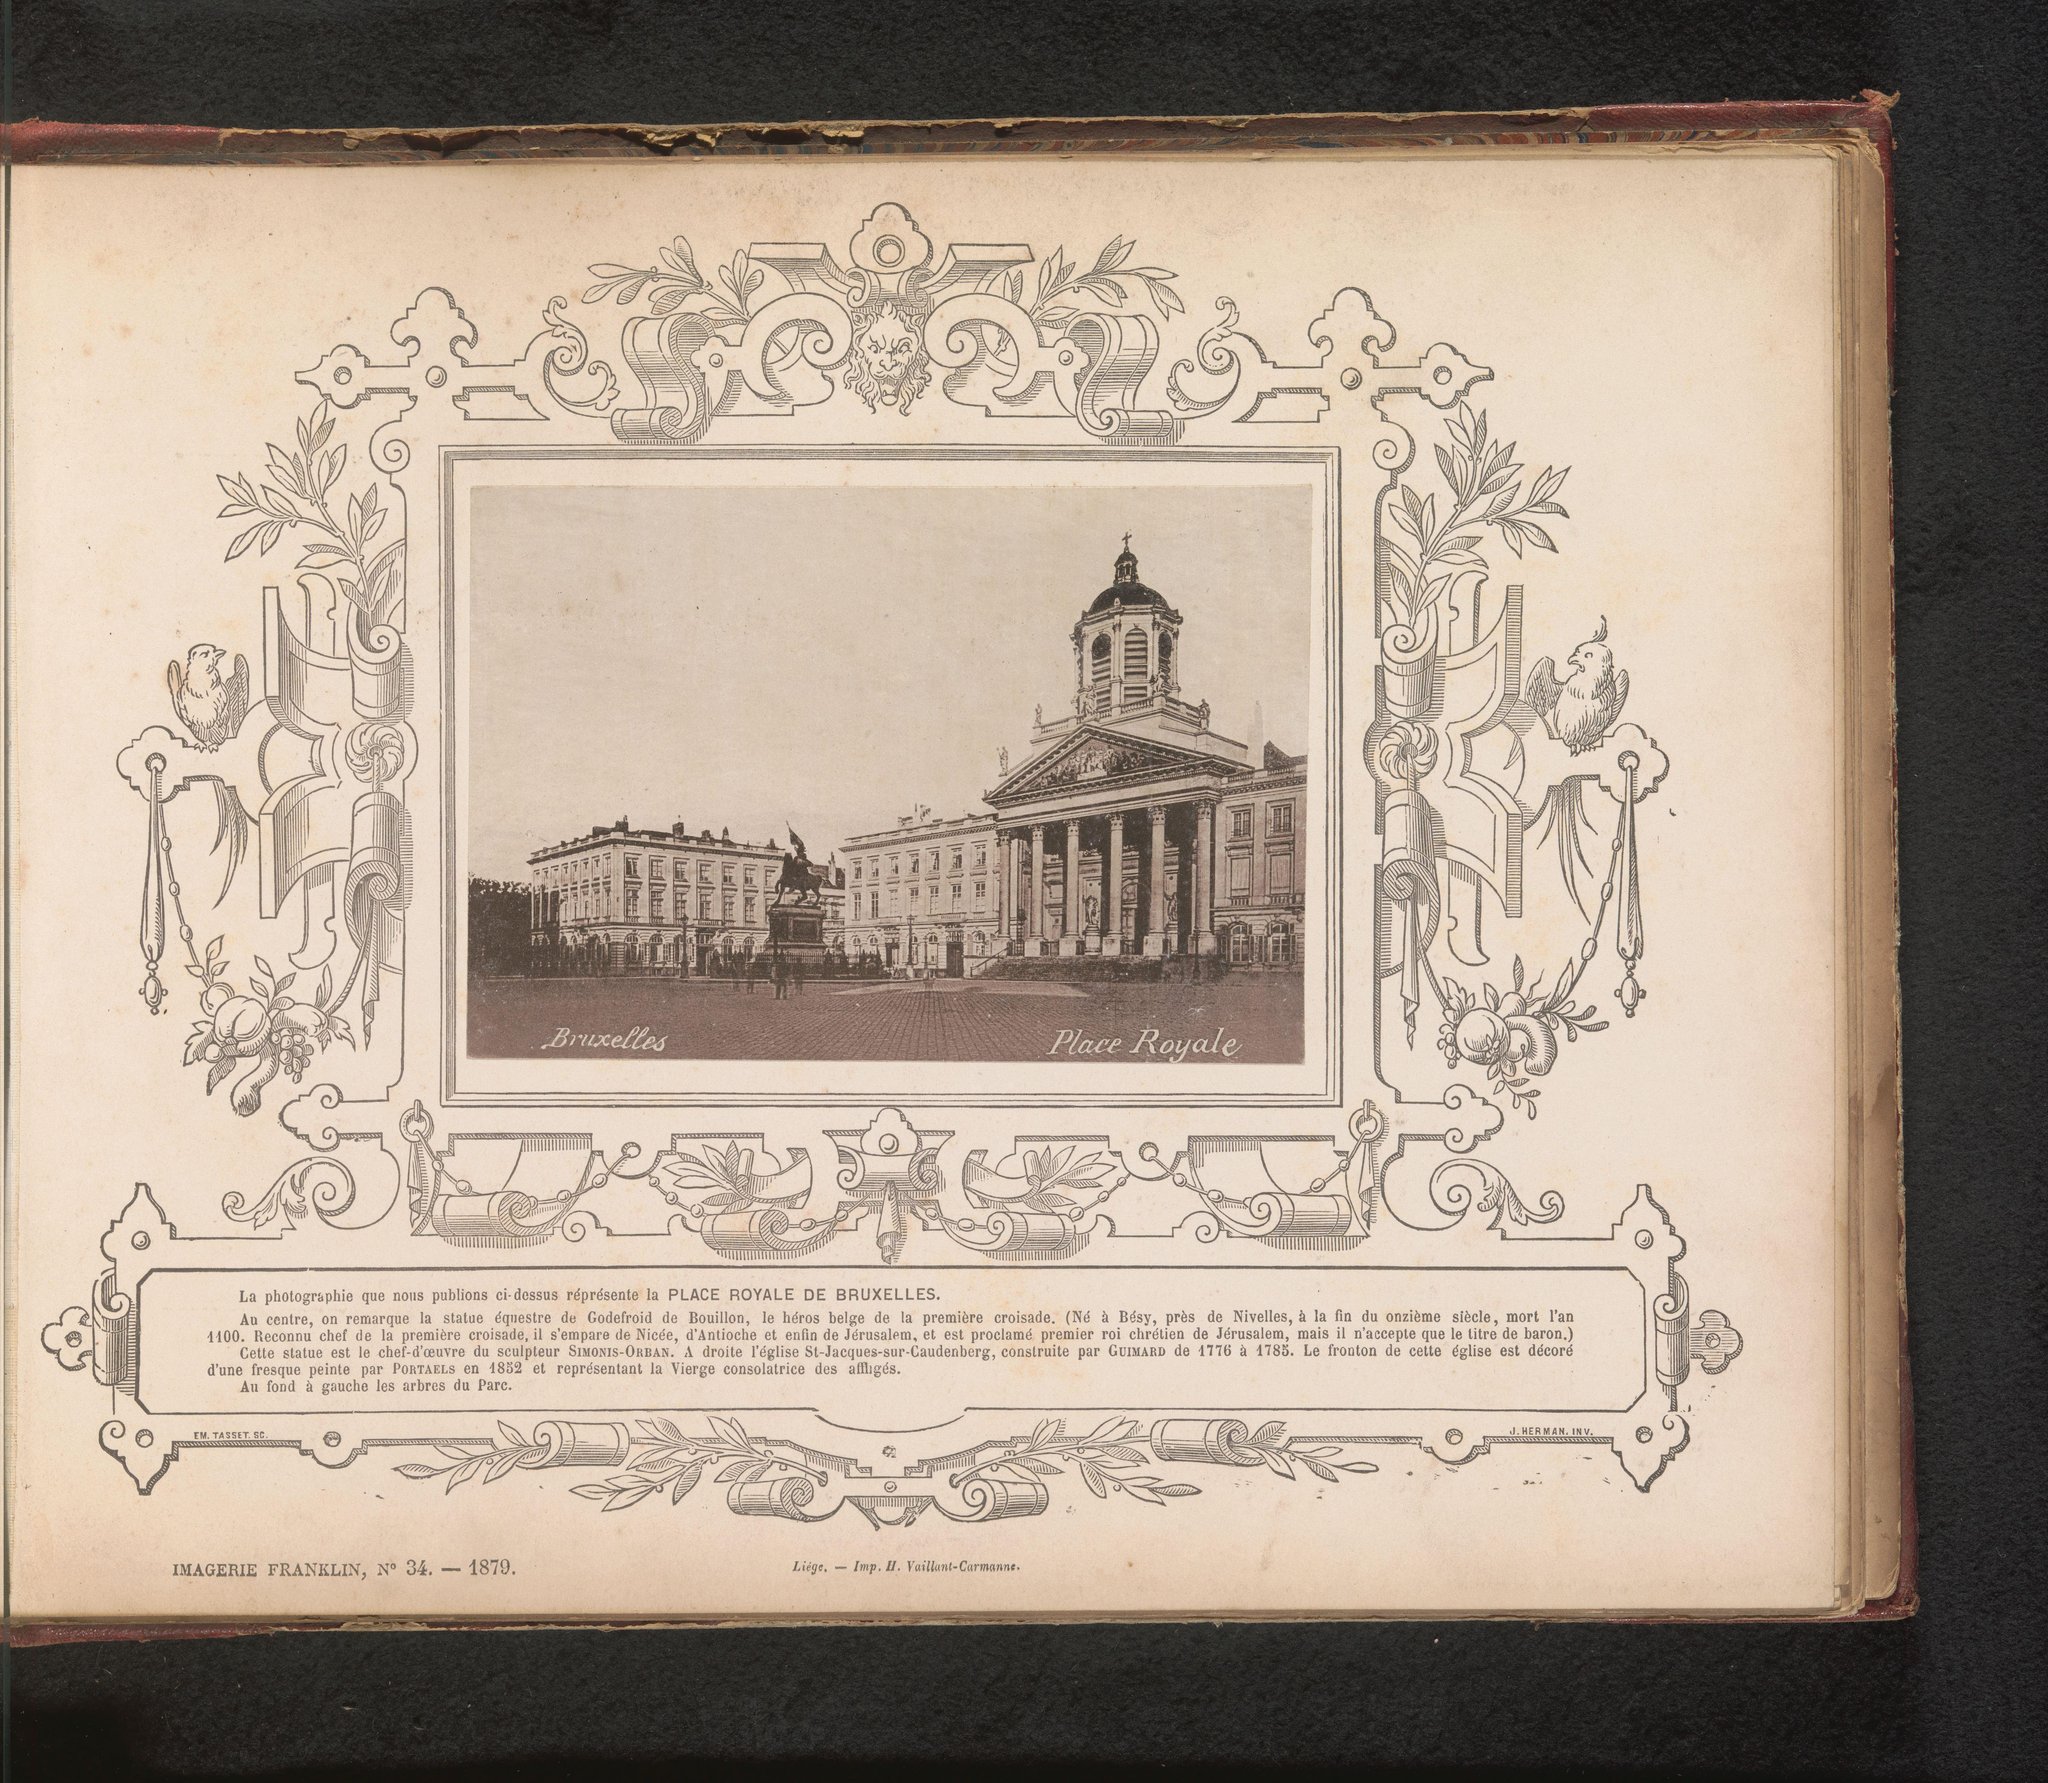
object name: page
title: Gezicht op Place Royale in Brussel, België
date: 1874-1879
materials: paper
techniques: photograph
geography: liège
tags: square, place, circus, etc., church (exterior)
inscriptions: name: ‘EM. TASSET, SC.’, inscription: ‘La photographie (...) du Parc.’, inscription: ‘IMAGERIE FRANKLIN, No 34. -1879.’, name: ‘J. HERMAN, INV.’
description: Deze prent maakt deel uit van een album.